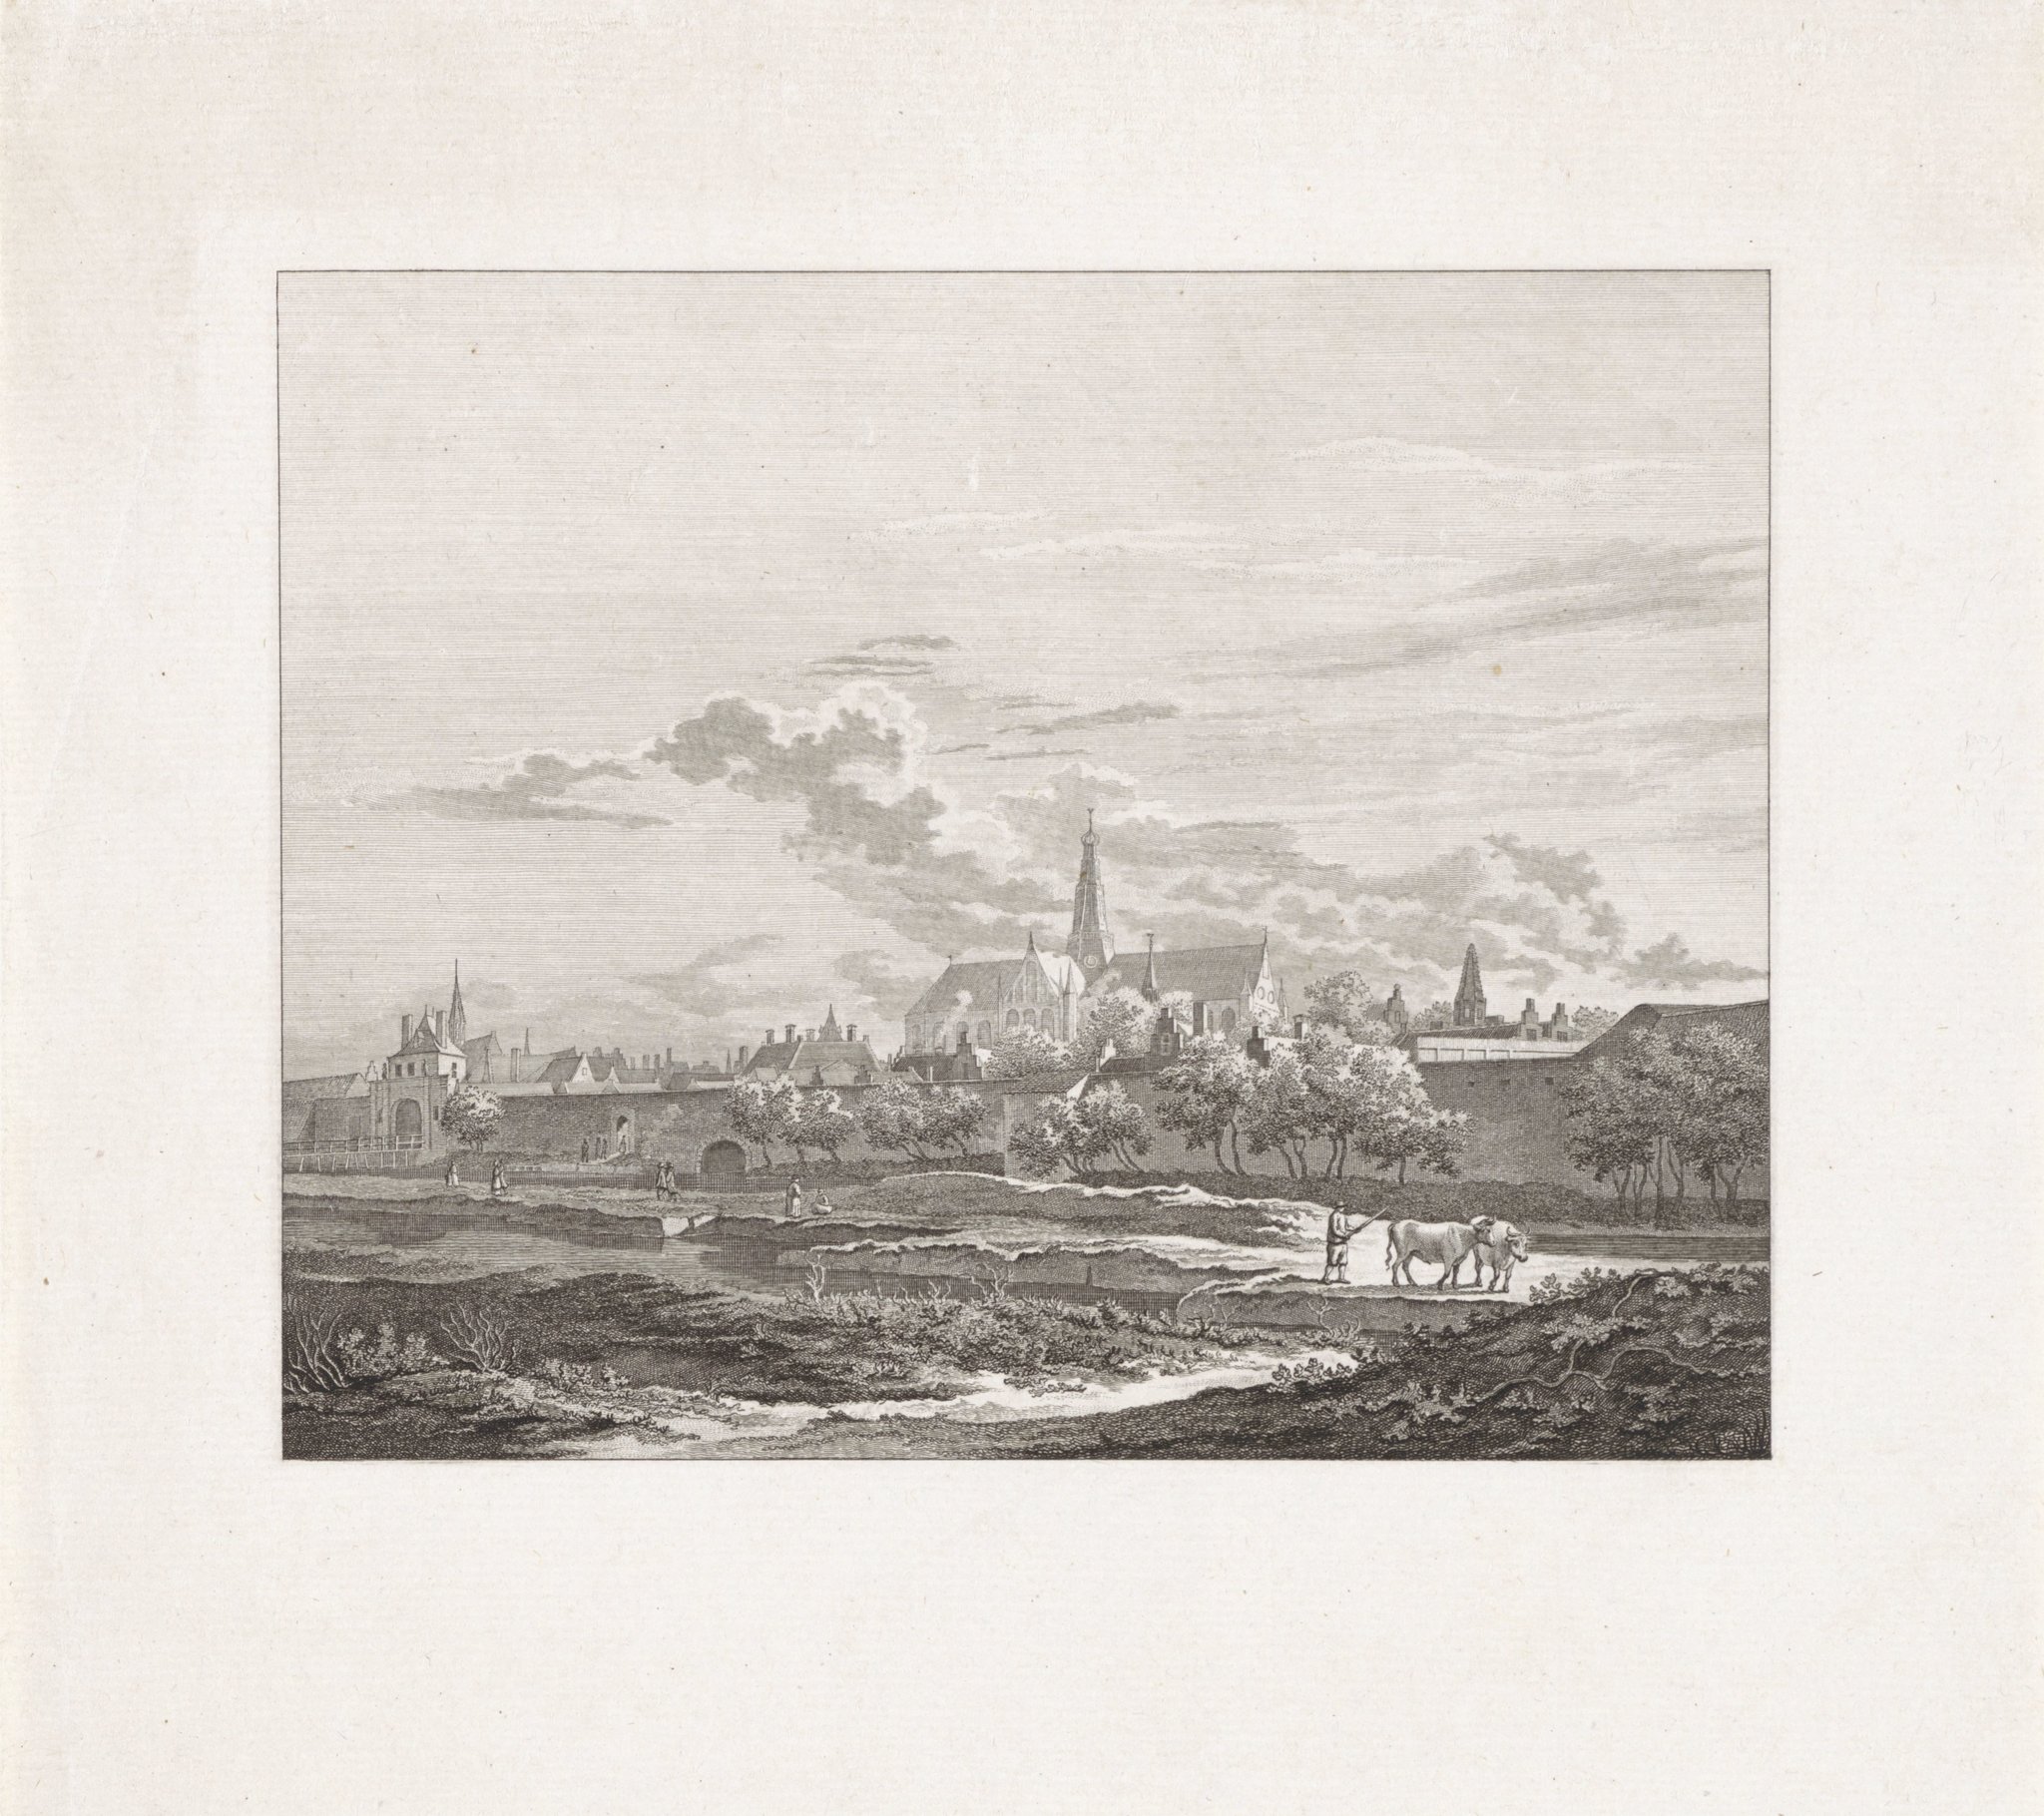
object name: print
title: Gezicht op Haarlem met de Sint-Bavokerk en de Kruispoort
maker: izaak jansz. de wit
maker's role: draughtsman, print maker, publisher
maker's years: 1744-1809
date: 1807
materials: paper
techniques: etching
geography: haarlem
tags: city-walls, city-gate, haarlem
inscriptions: collector's mark: Lugt 2228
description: Latere staat prent gebruikt in: Koning, Cornelis de. Tafereel der stad Haarlem : en derzelver geschiedenis van de vroegste tijden af tot op den tegenwoordigen toe. 4 dln. Haarlem: Adriaan Pietersz. Loosjes, 1807-1808.